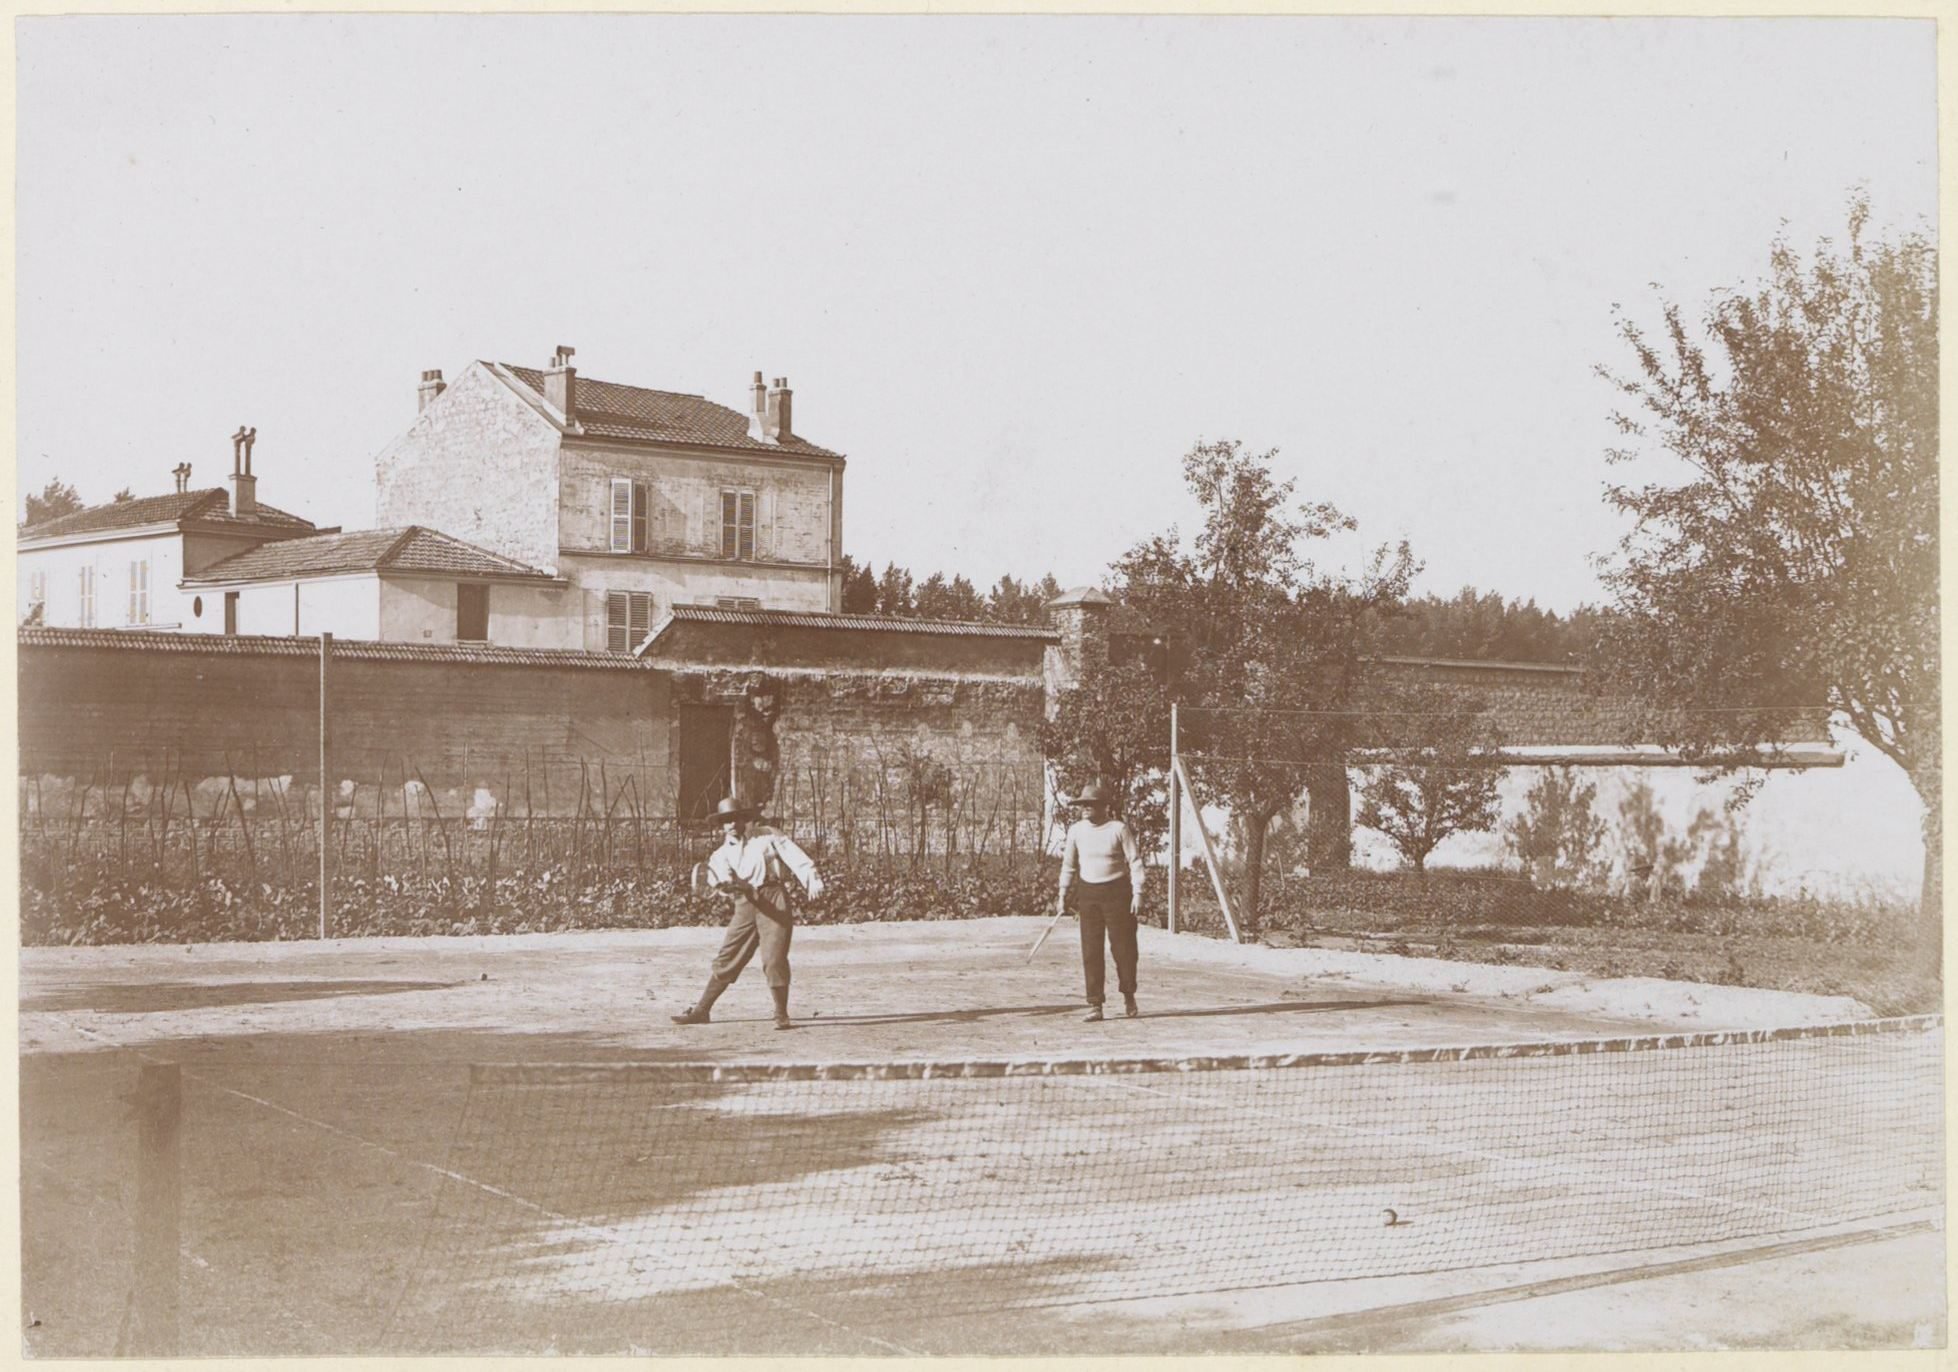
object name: photograph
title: Twee tennisspelers op een ommuurde tennisbaan, vermoedelijk in Frankrijk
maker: Anonymous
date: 1900-1910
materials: paper, photographic support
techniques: daylight paper print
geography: france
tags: tennis, lawn-tennis, france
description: Onderdeel van Fotoalbum van een Franse amateurfotograaf met opnames van een familie, distilleerderij Delizy & Doistau Fils, het leger en bezienswaardigheden in Frankrijk.